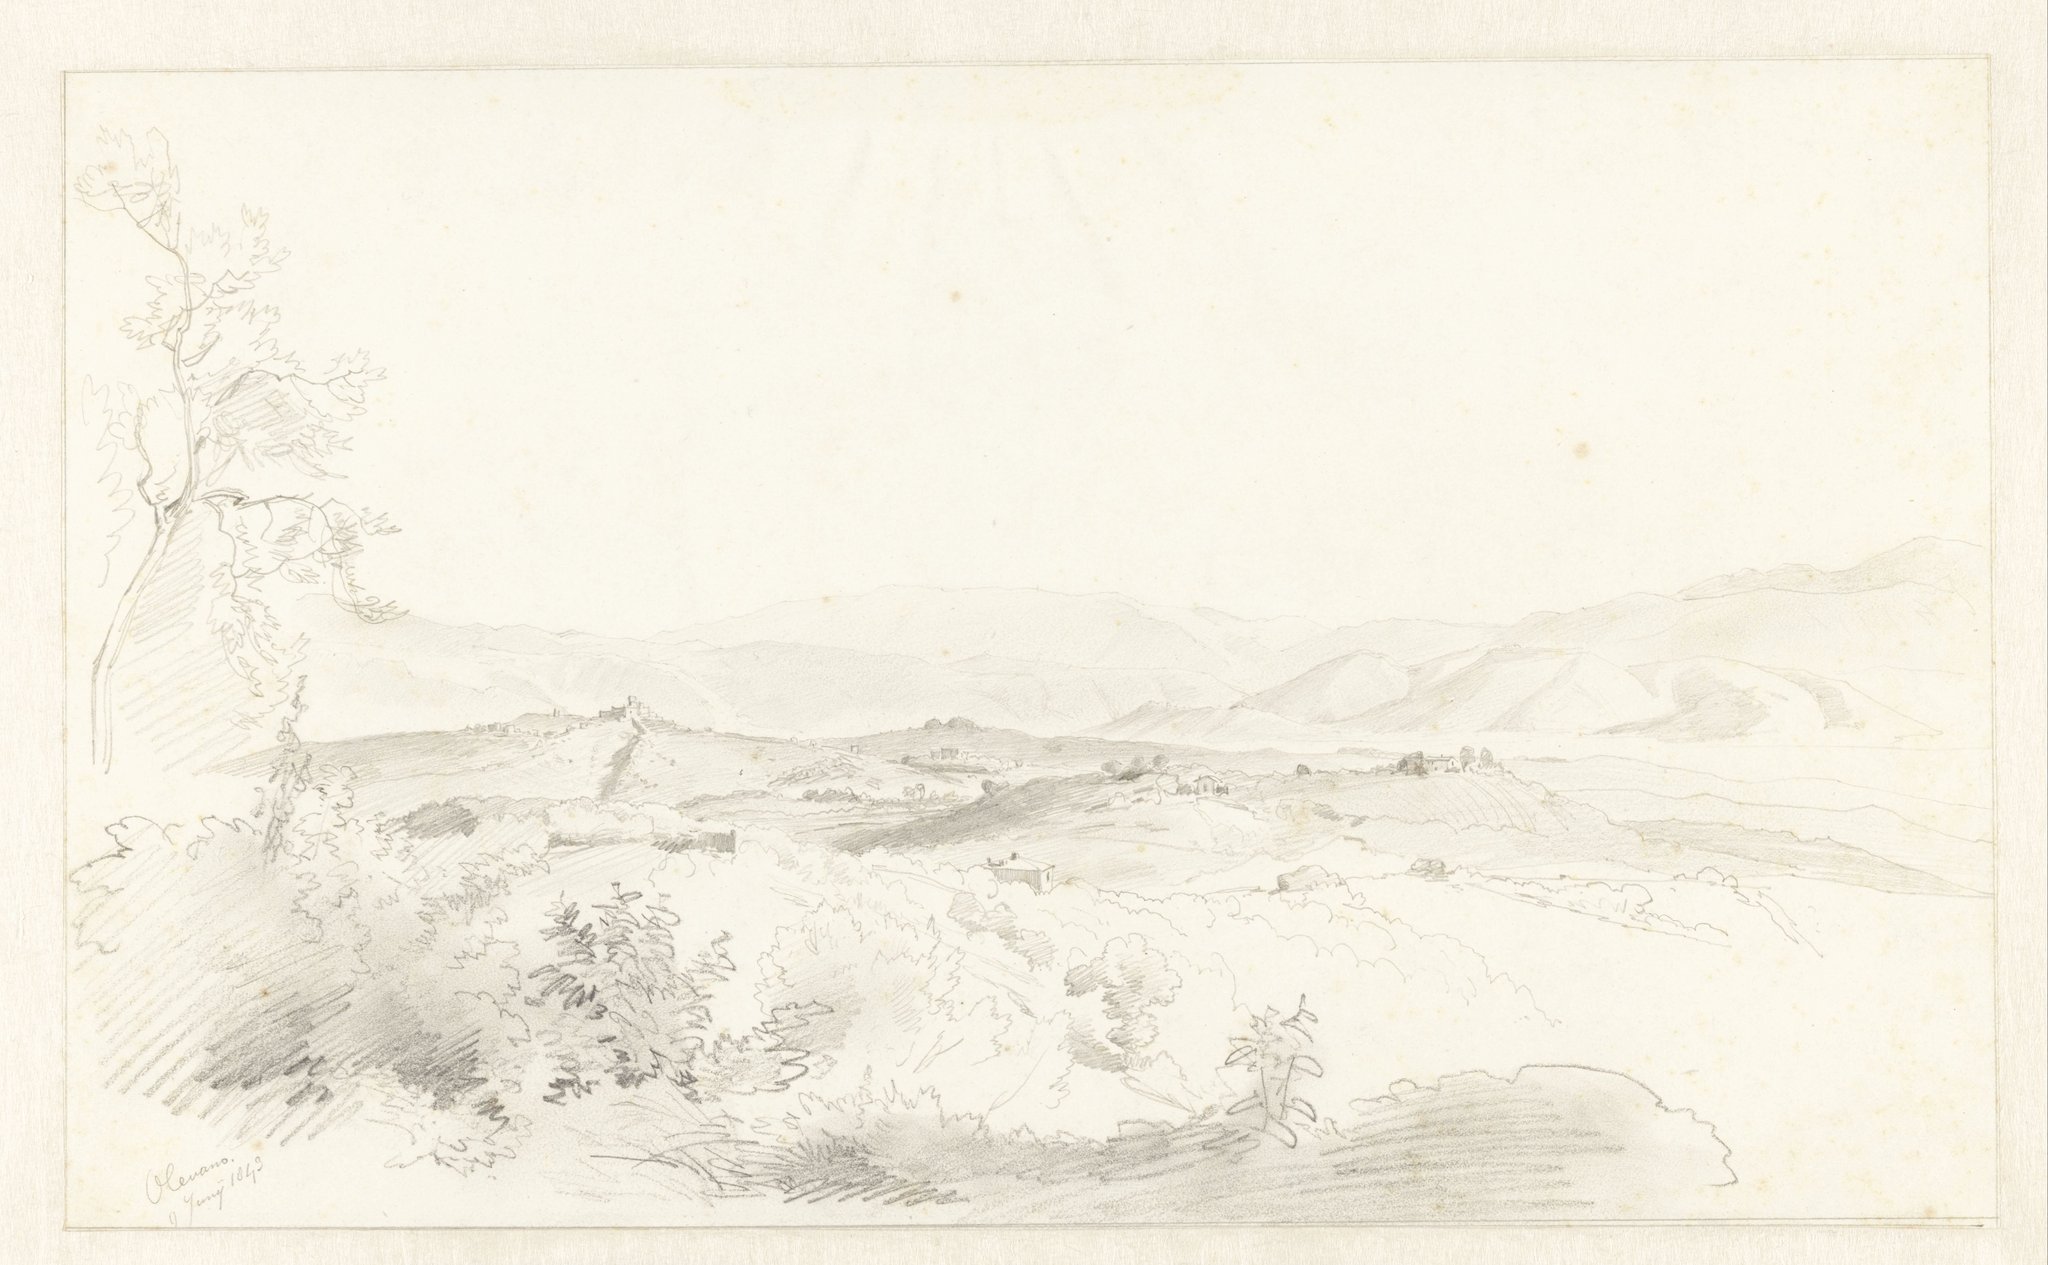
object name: drawing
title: Olevano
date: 1843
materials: chalk, paper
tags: low hill country, italy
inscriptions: date and inscription: ‘Olevano / 9 Juny 1843’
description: Tekening uit een groep tekeningen van landschappen en stadsgezichten in Italië (Rome, Tivoli, Civita Castellana en Pozzuoli).